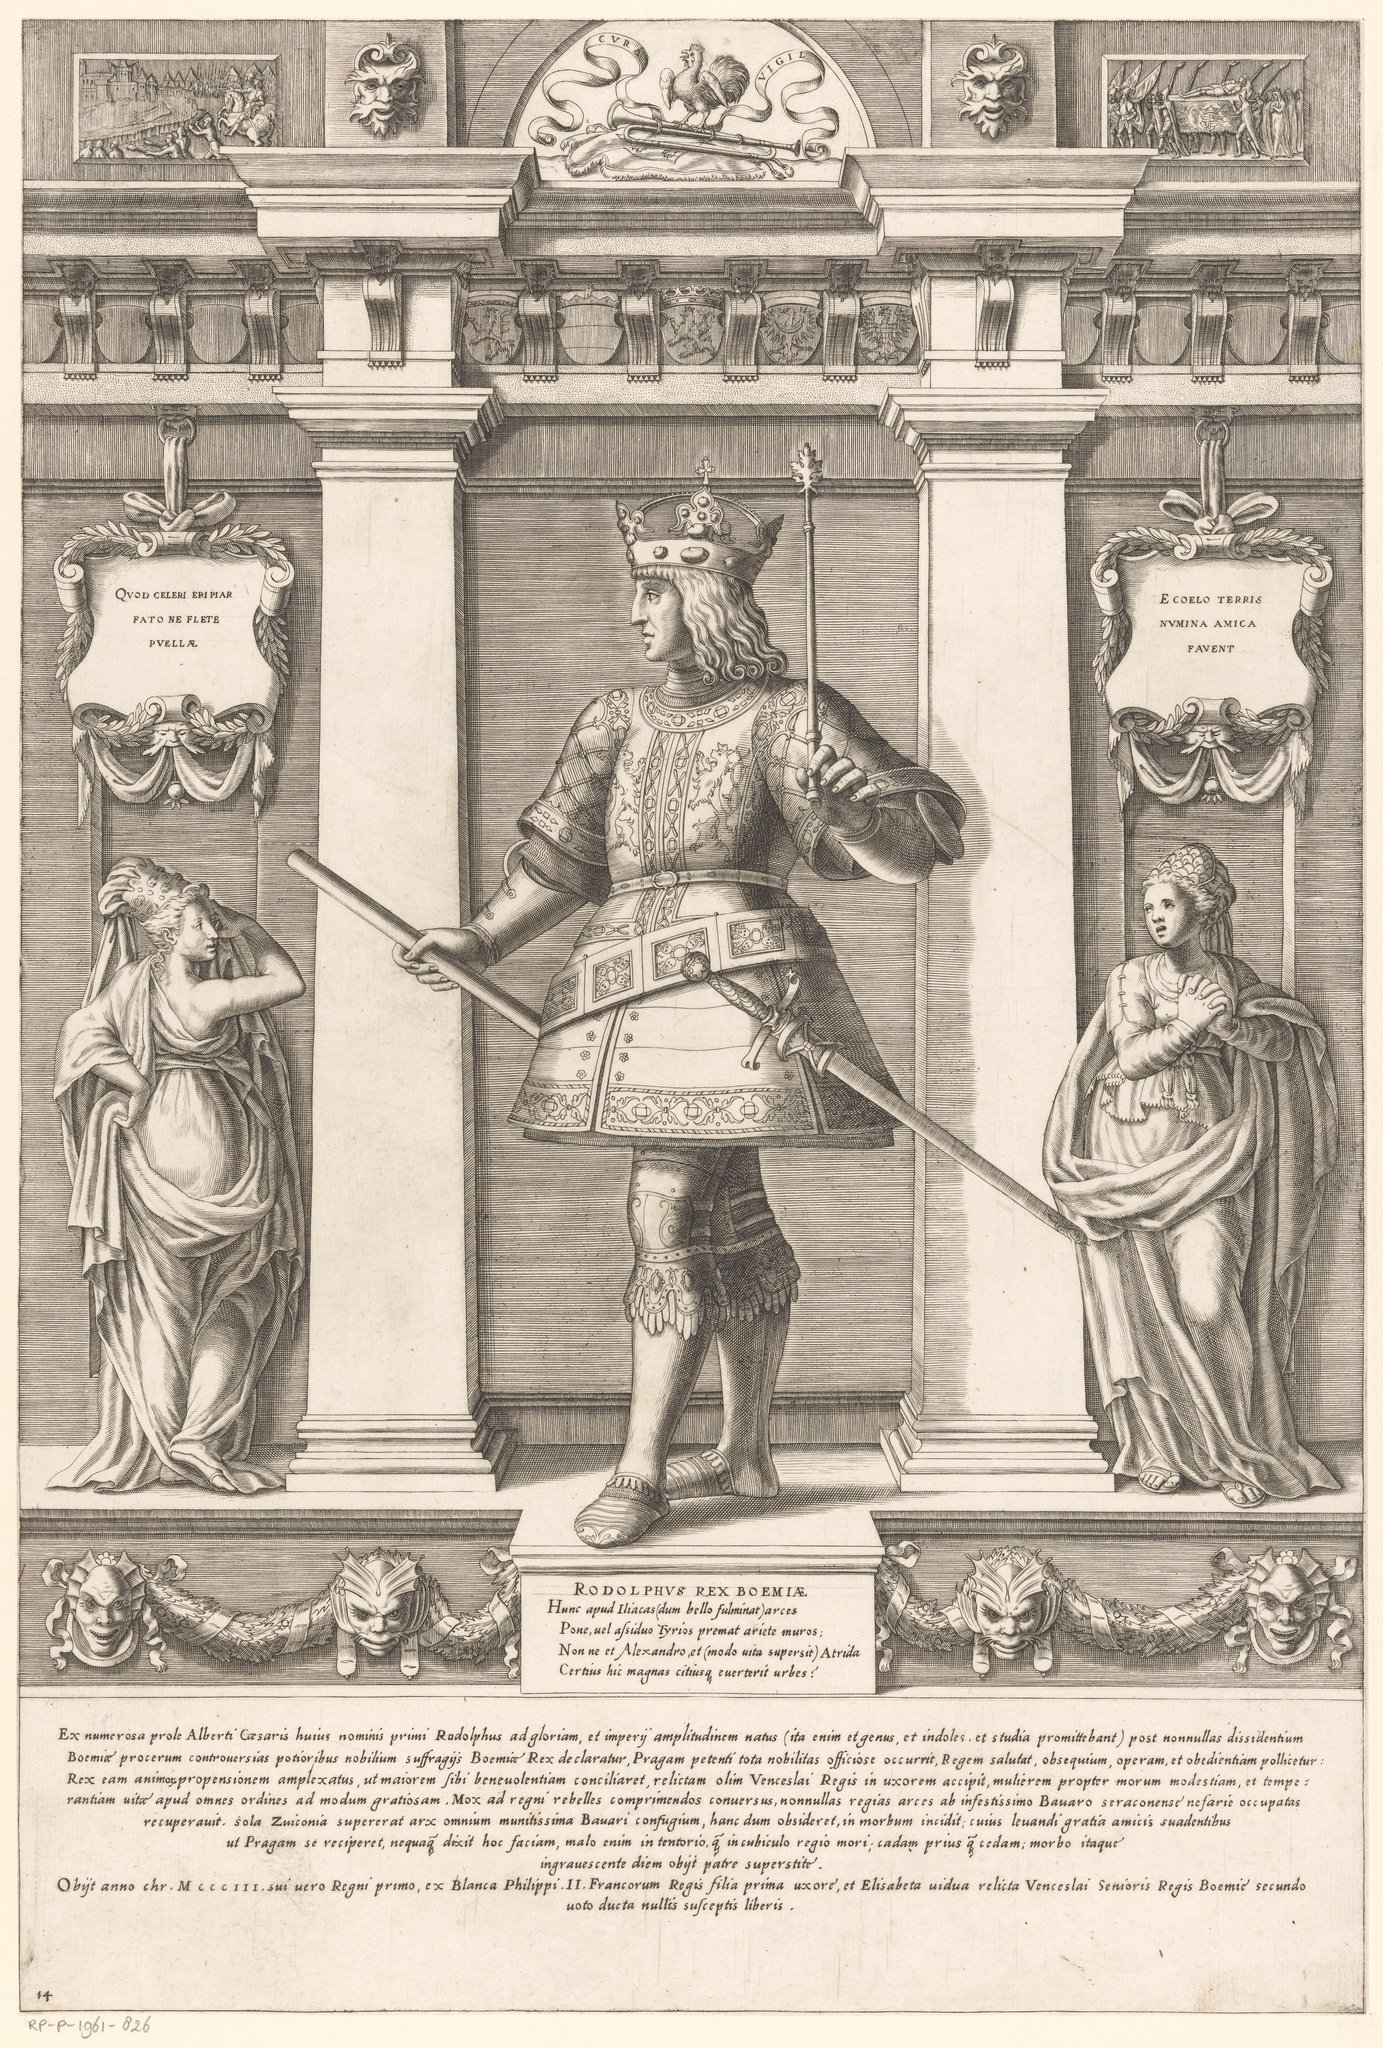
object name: print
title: Portret van Rudolf I van Bohemen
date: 1569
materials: paper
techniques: engraving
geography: italy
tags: historical persons, ruler, sovereign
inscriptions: collector's mark: Lugt 2228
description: Deze prent maakt deel uit van een reeks van 58 prenten. Het meerendeel van de prenten bevat portretten van 74 leden van het Oostenrijkse Huis, naar tekeningen door Francesco Terzio, die deels getekend zijn naar de 28 levensgrote bronzen beelden die rond de cenotaaf van Maximiliaan I in de Hofkirche te Innsbruck staan.